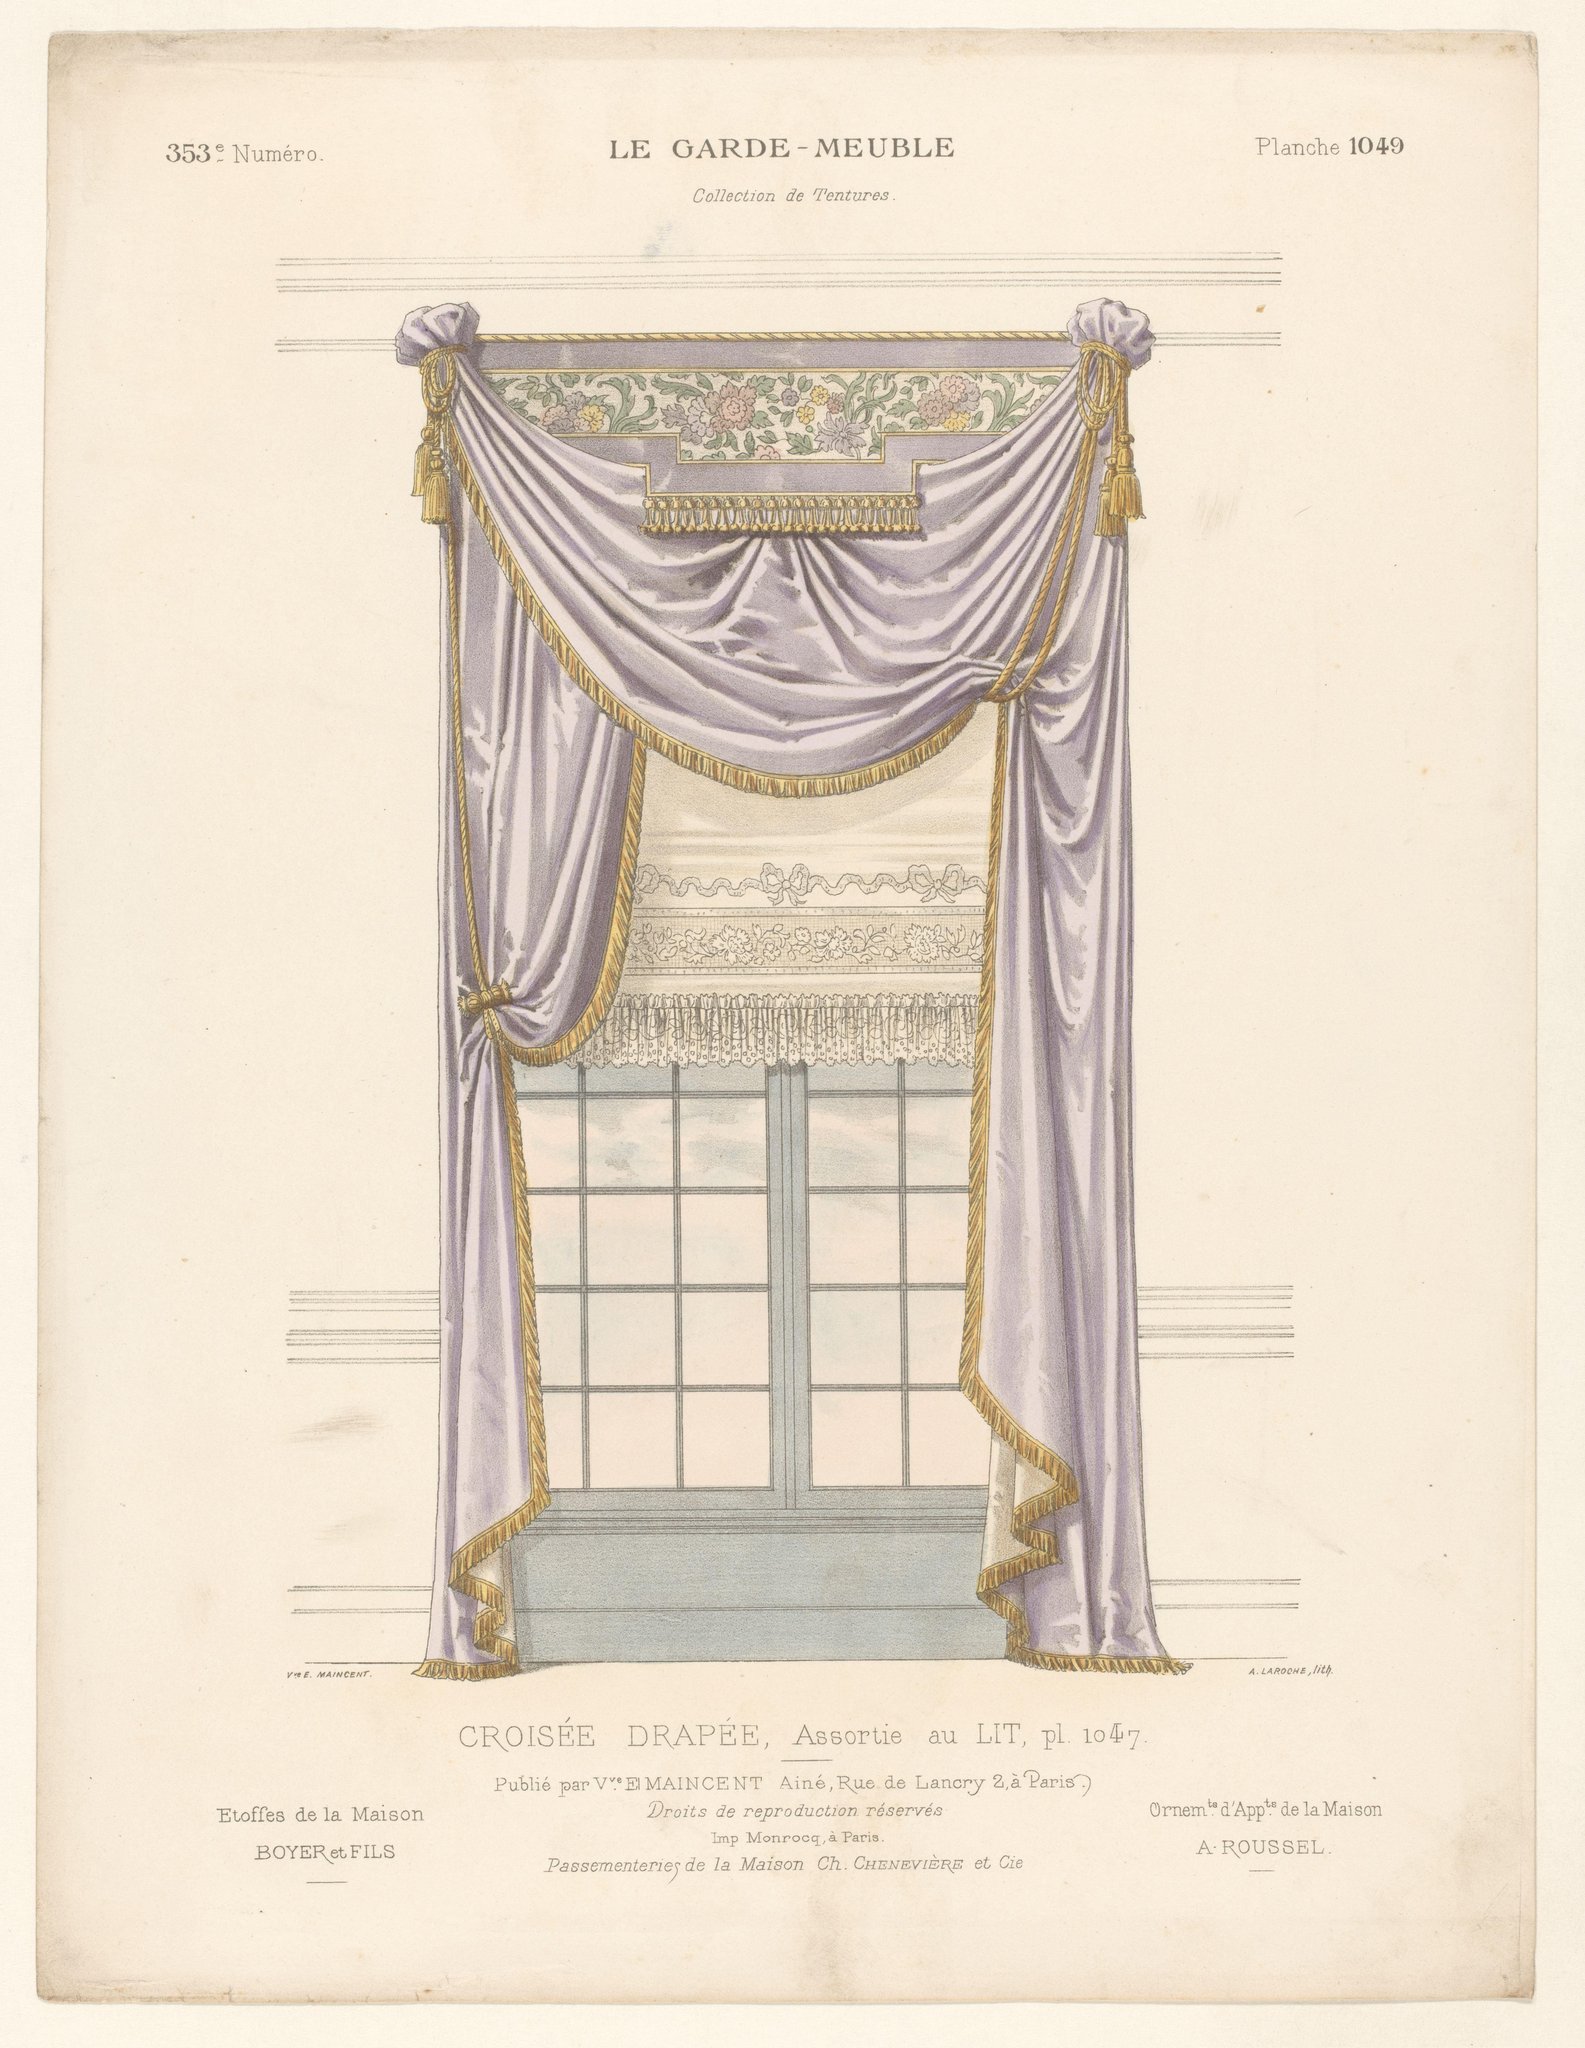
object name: print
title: Le Garde-Meuble / Collection de Tentures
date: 1895-1910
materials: paper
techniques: hand coloring, lithograph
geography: paris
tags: window, hangings and drapery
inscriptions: : ‘Droits de reproduction réservés.’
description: Kruisvenster met gedrapeerde gordijnen, passend bij het bed van serienr. 1047. Prent uit 353e Livraison.